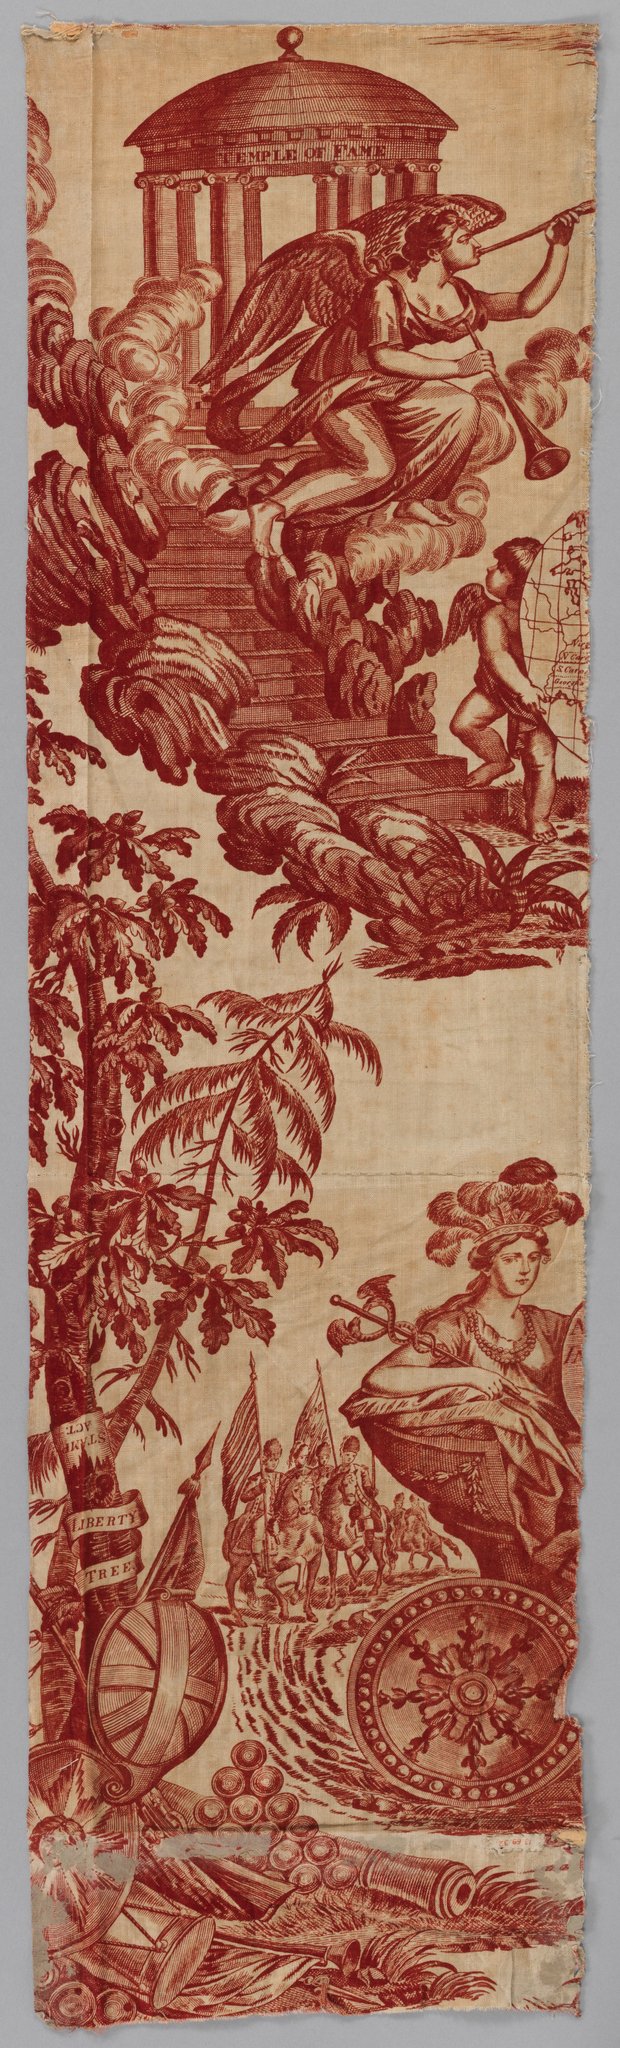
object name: piece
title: Apotheosis of Franklin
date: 1780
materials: cotton, linen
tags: american revolution,women